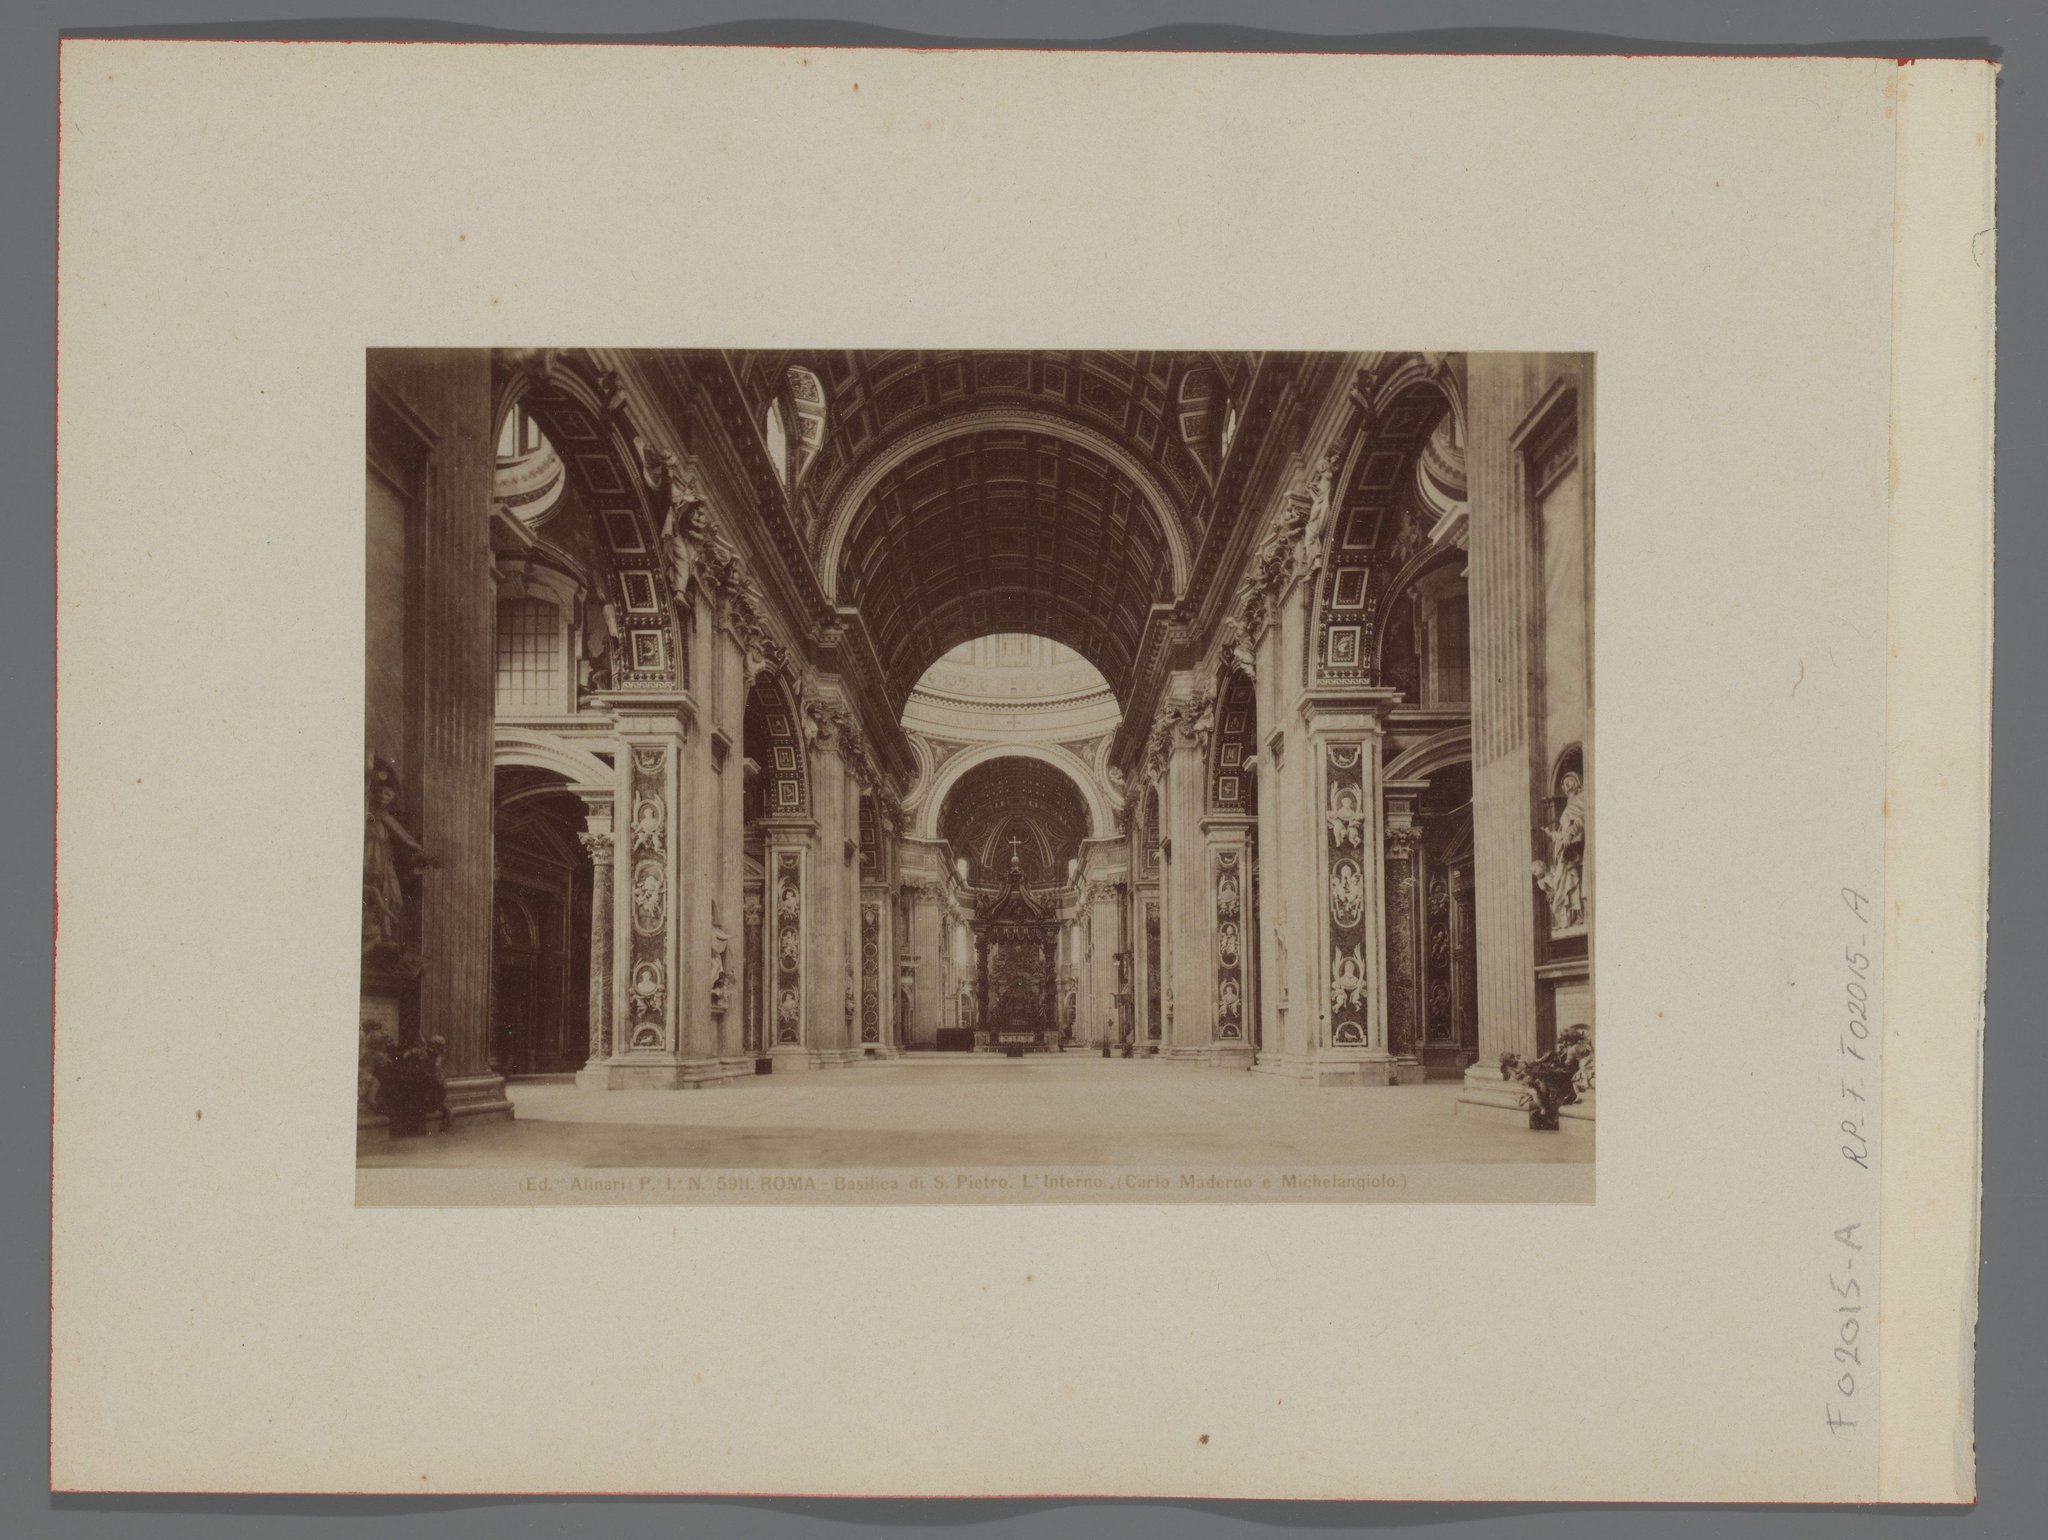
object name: photograph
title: Basilica di S. Pietro. L'Interno (Carlo Maderna e Michelangiolo)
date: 1852-1900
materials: cardboard, paper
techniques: albumen print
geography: vatican city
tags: interior of church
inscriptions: number: ‘Po. Io. No. 5911.’